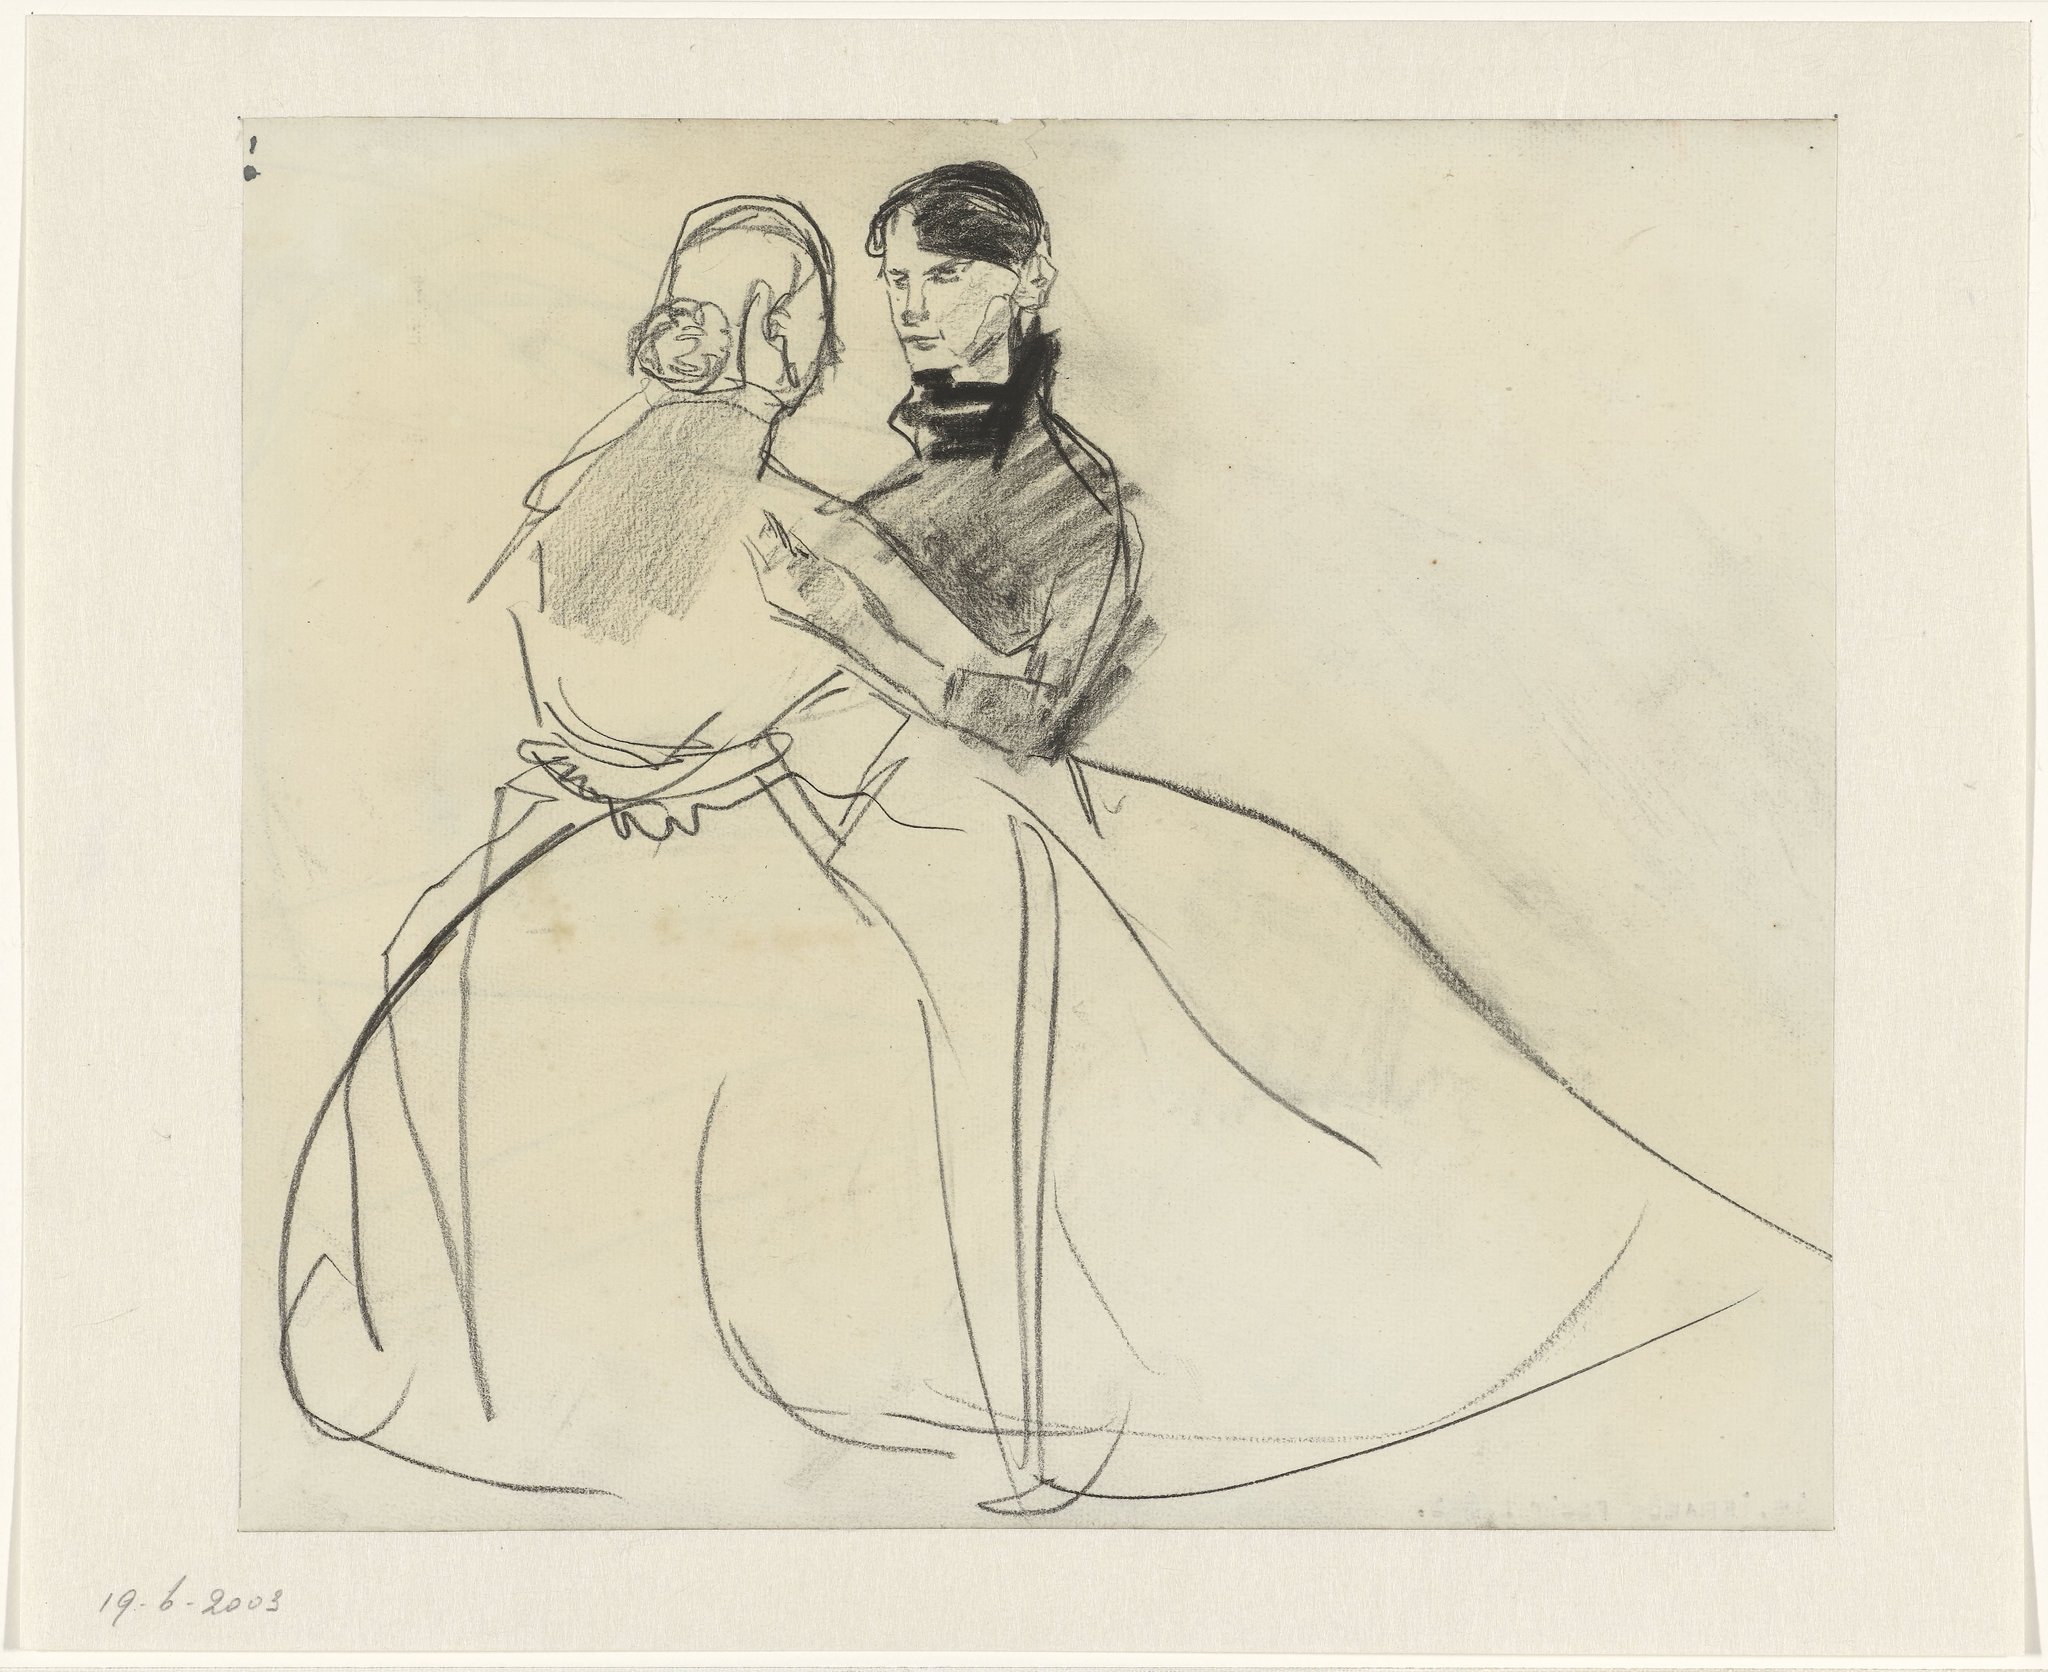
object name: drawing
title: Twee dansende vrouwen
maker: isaac israels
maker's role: draughtsman, painter, print maker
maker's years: 1865-1934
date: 1892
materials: chalk, paper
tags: two women dancing as a couple